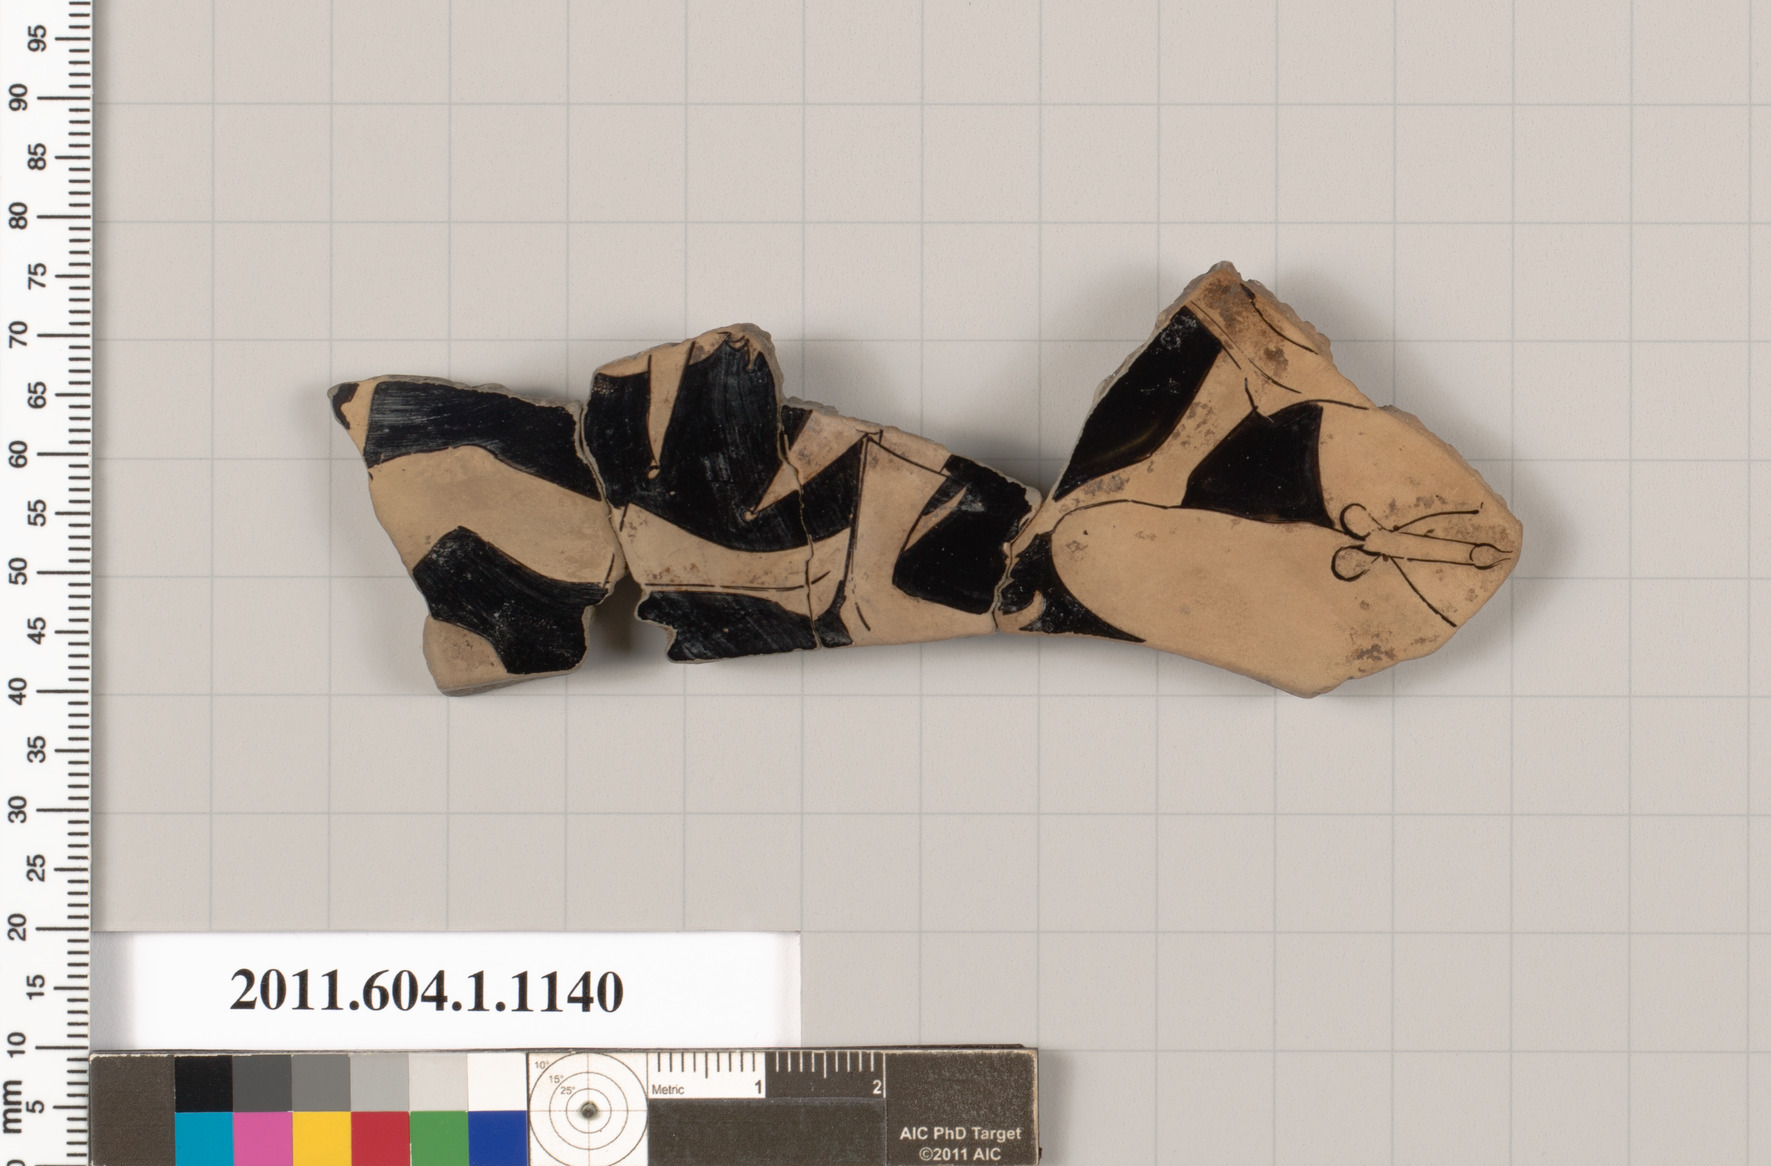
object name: kylix fragment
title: Terracotta fragment of a kylix (drinking cup)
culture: greek, attic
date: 500-480 BCE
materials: terracotta